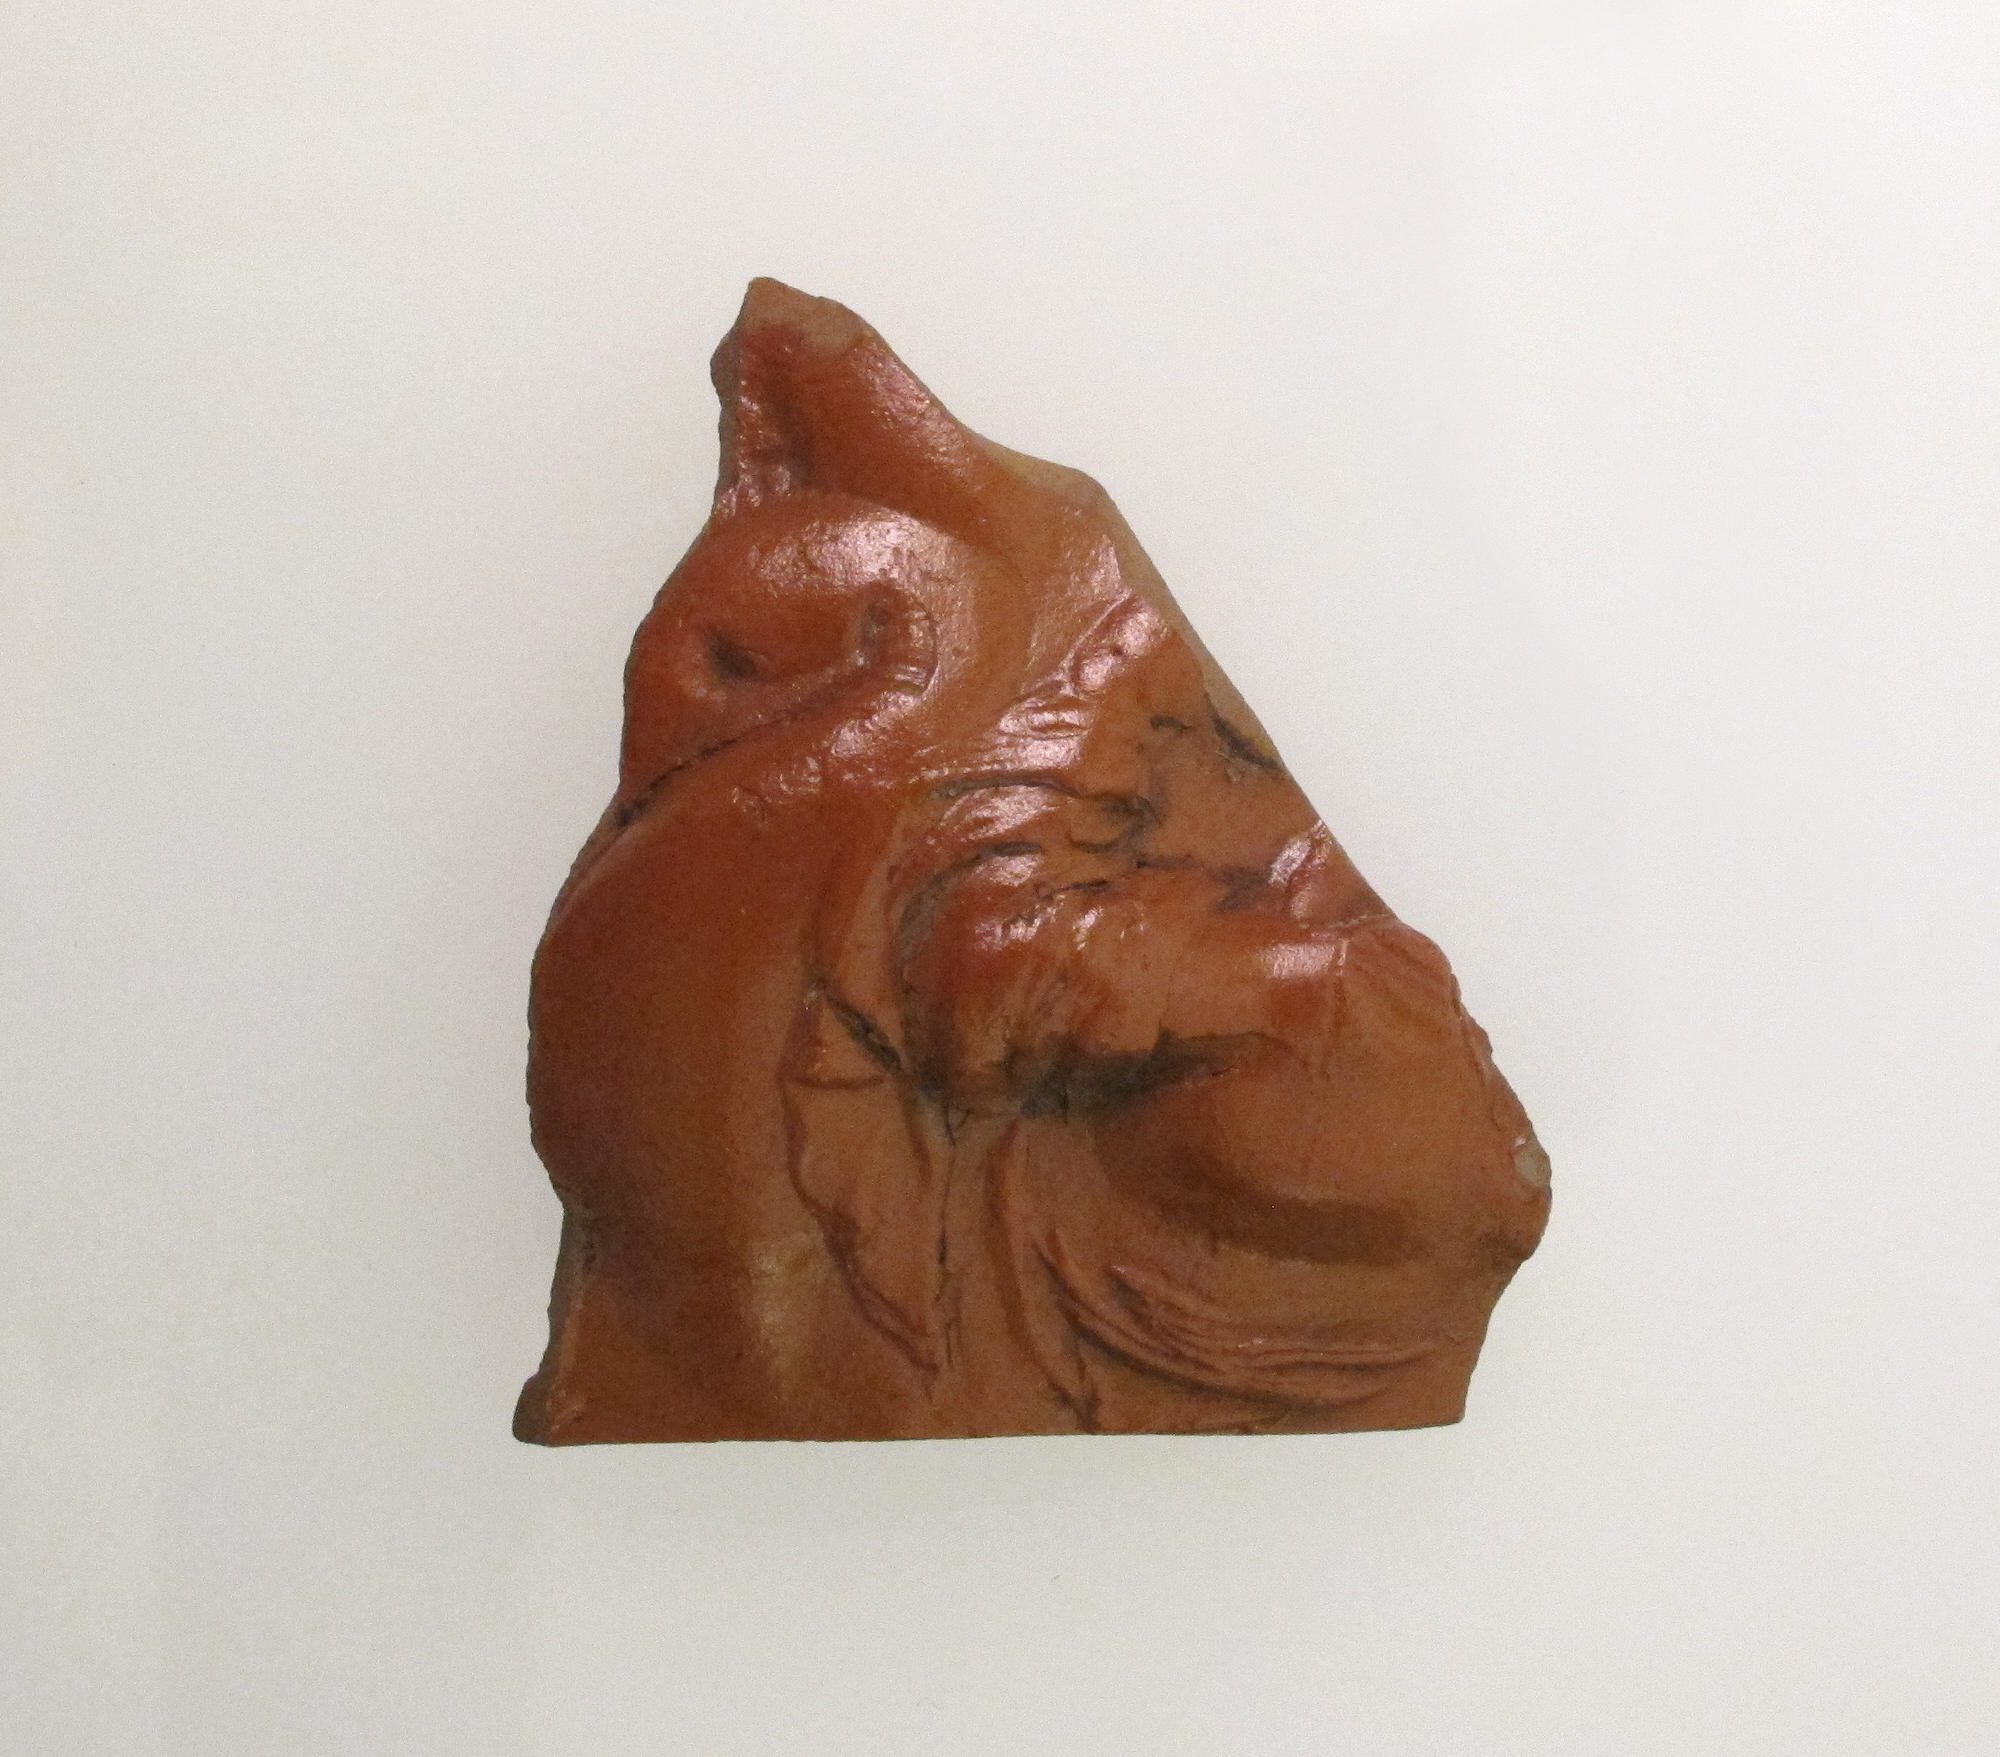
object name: vase fragment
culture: roman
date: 100 BCE-100 CE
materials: terracotta